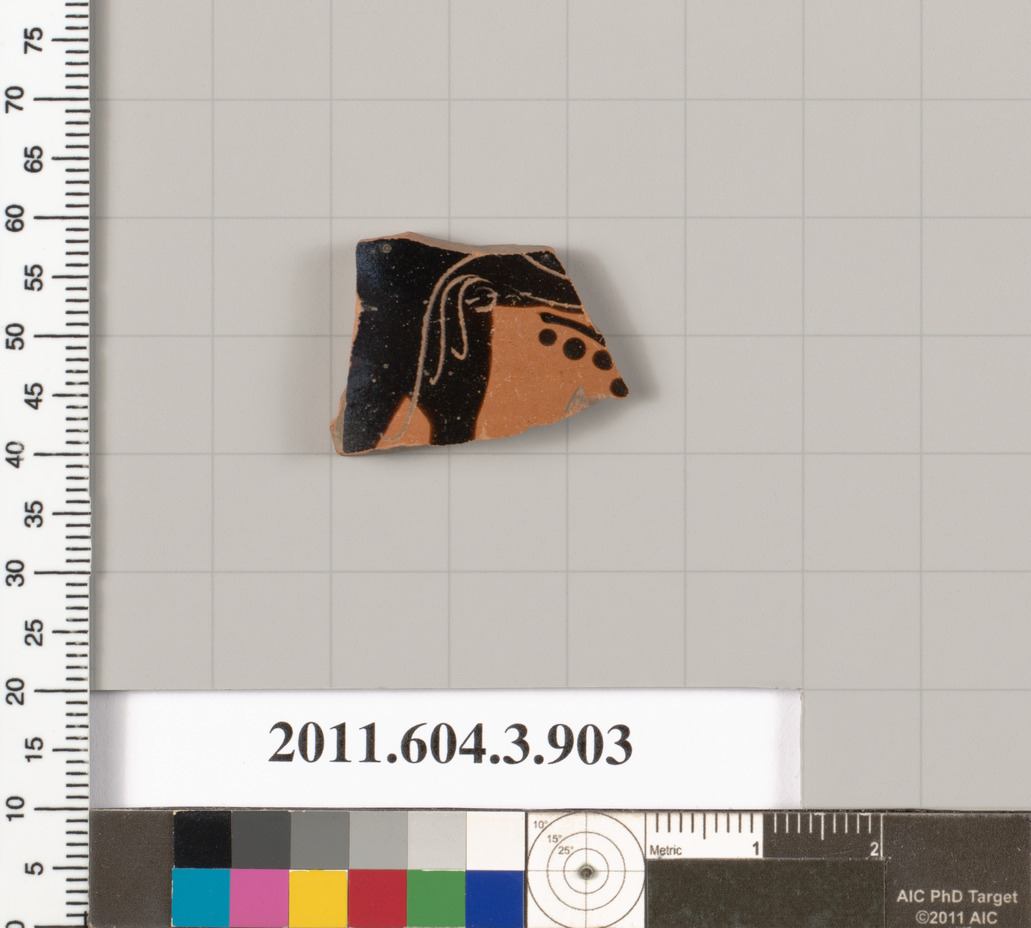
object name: lekythos fragment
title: Terracotta fragment of a lekythos (oil flask)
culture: greek, attic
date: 534-468 BCE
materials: terracotta